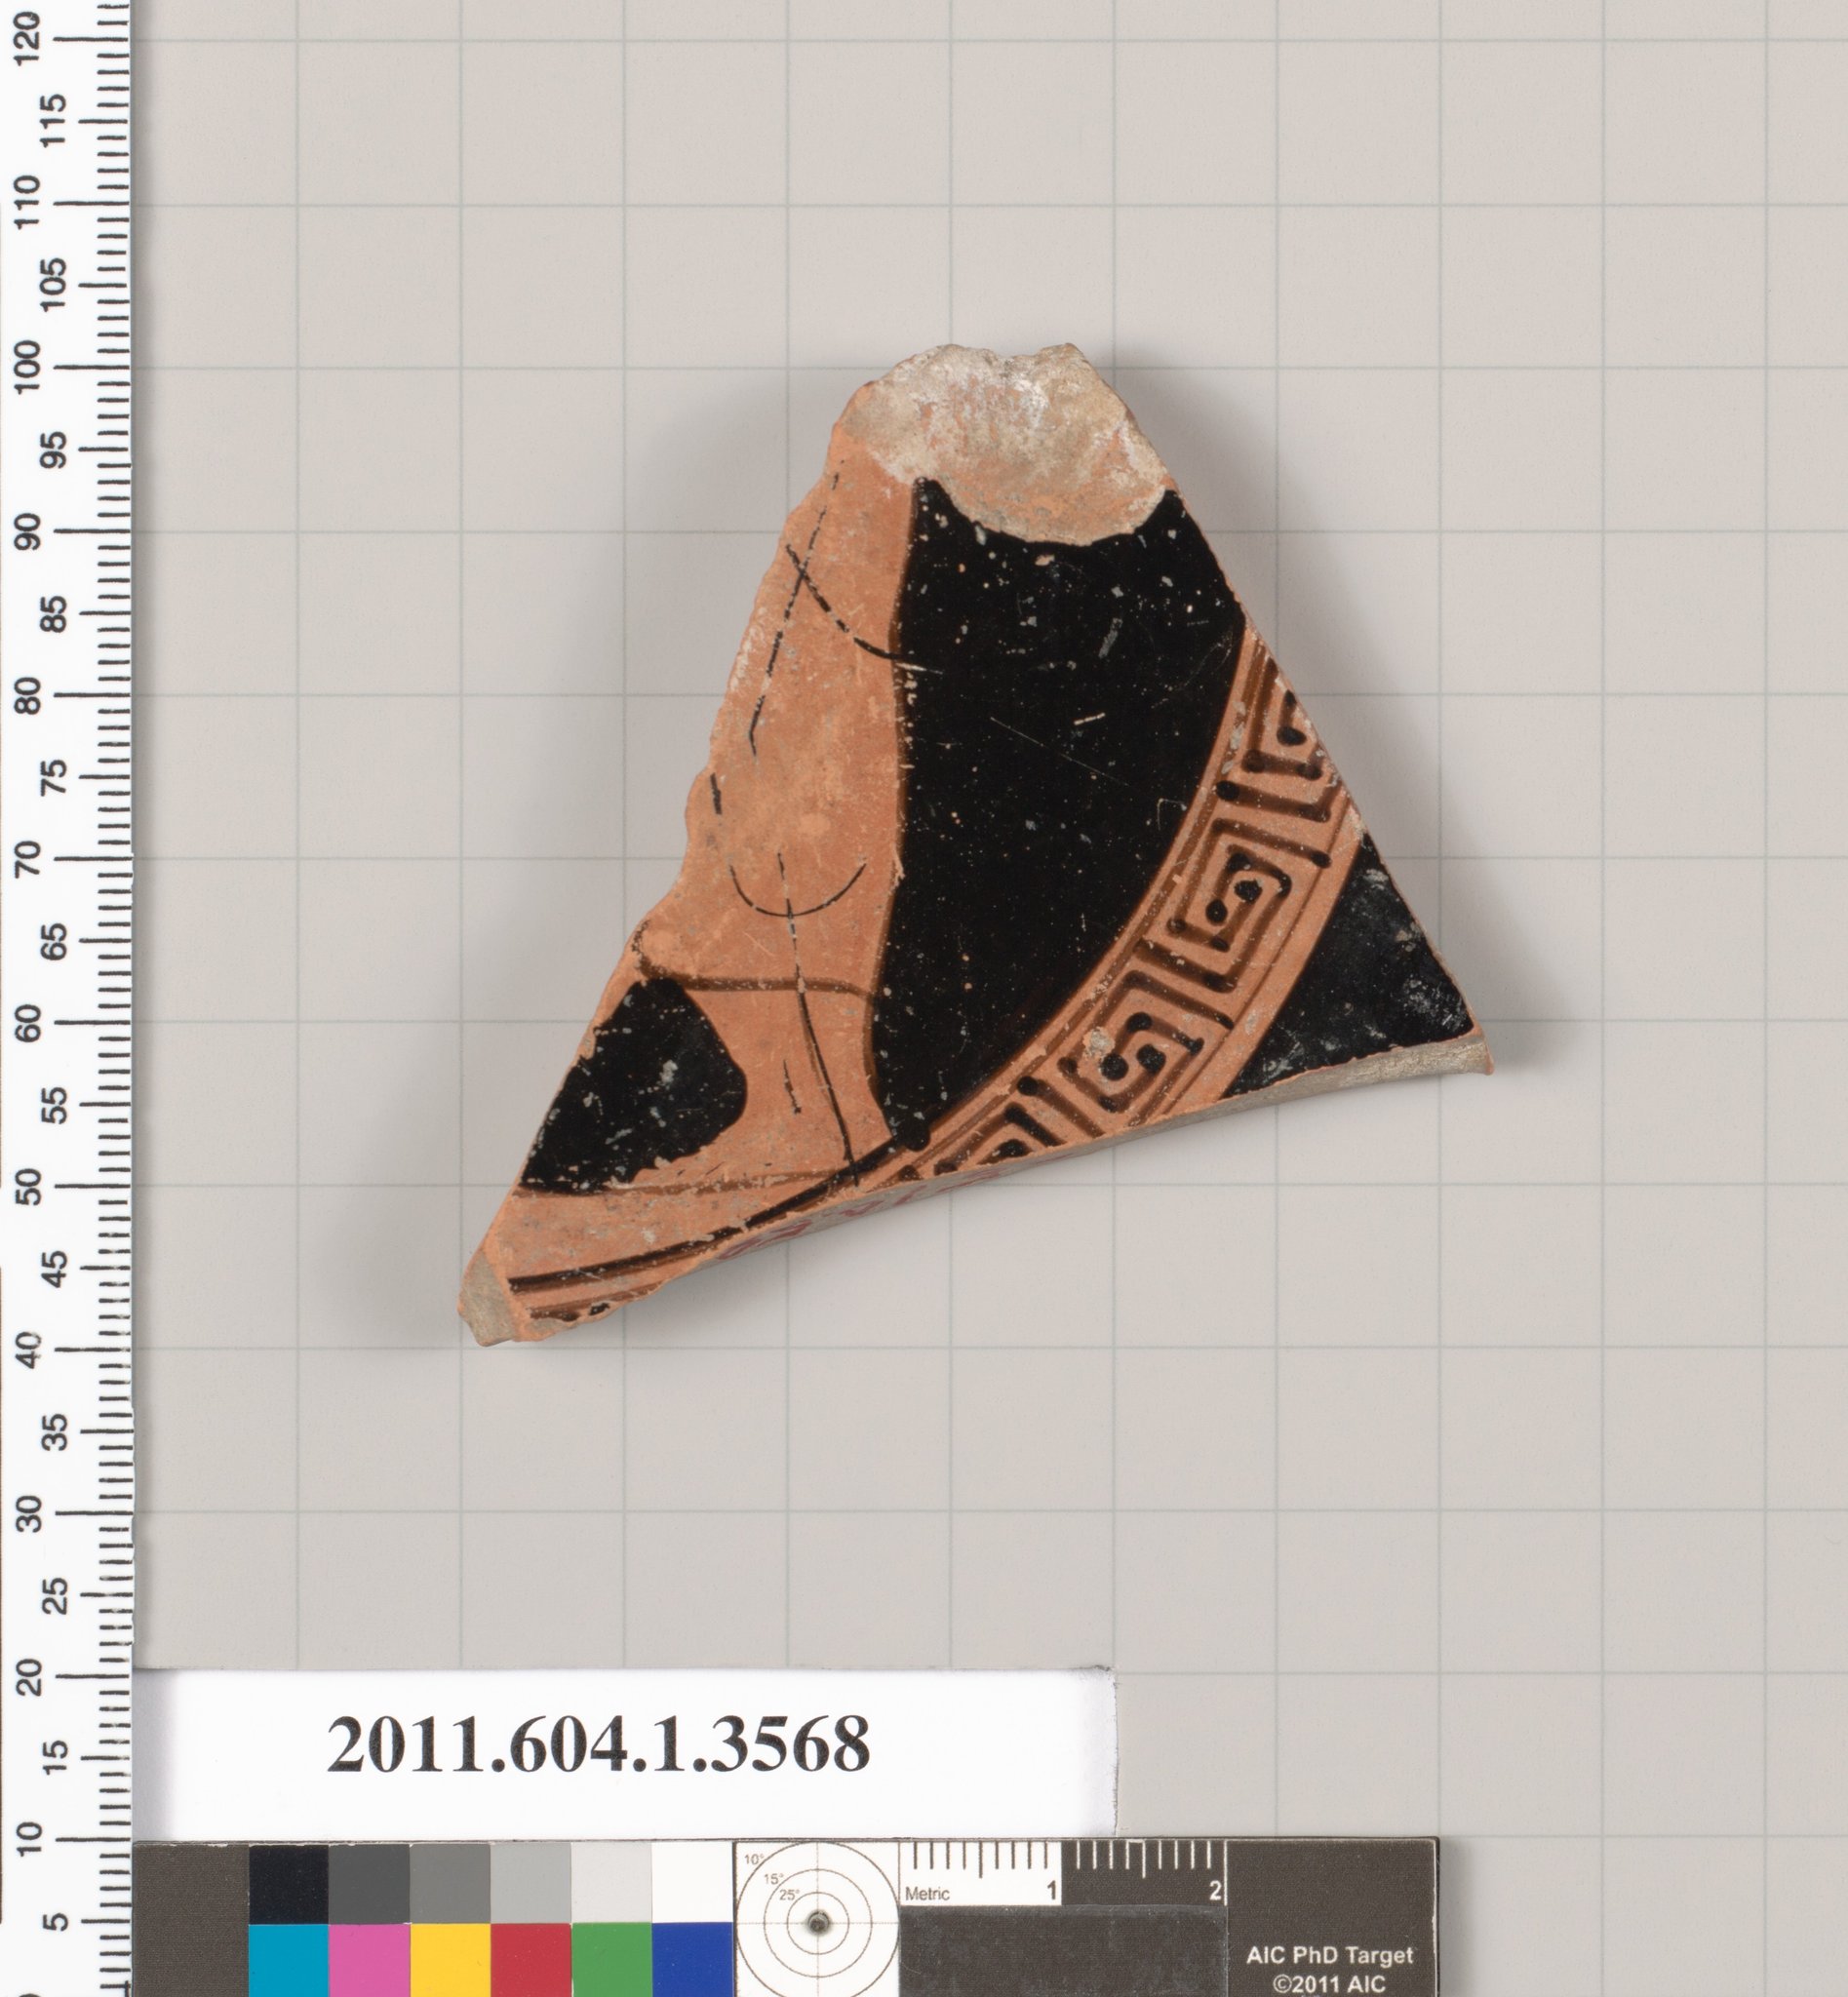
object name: kylix fragment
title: Terracotta fragment of a kylix (drinking cup)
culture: greek, attic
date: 475-451 BCE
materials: terracotta